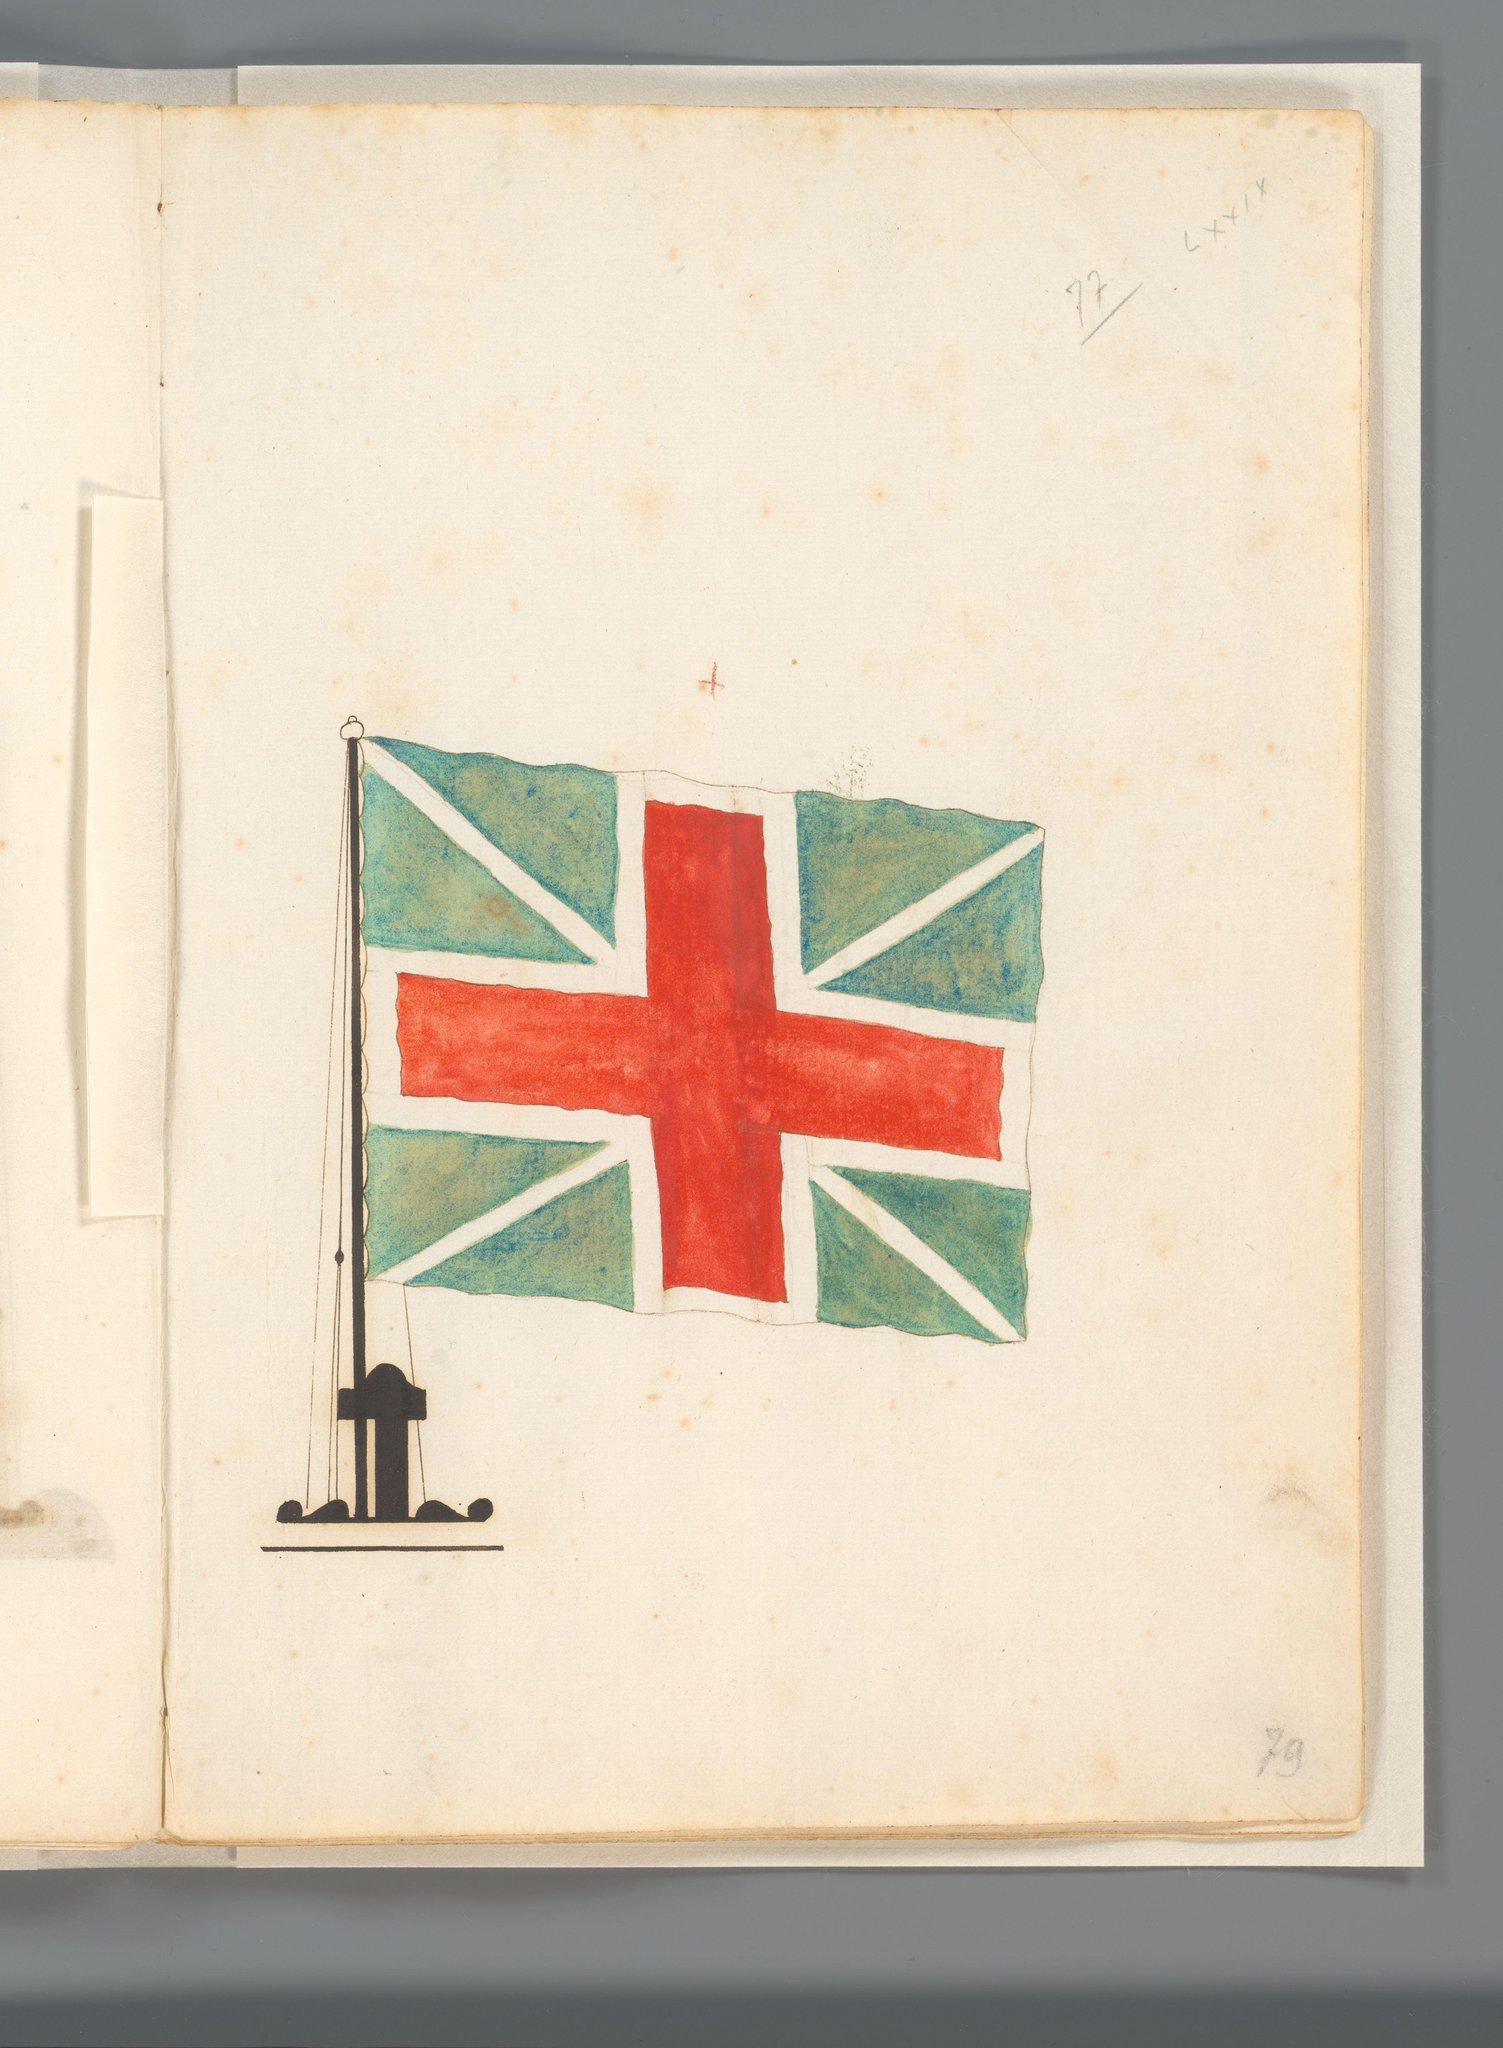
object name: drawing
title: Vlag van Groot-Brittannië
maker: Anonymous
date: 1667-1670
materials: ink, paper, watercolor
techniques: brush, pen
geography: france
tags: flag, colours (as symbol of the state, etc.), great britain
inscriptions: number: ‘77 / LXXIX / 79’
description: Vlag van Groot-Brittannië. Combinatie van het rode kruis van Sint-Joris (Saint George's Cross), de Engelse vlag, met een wit andreaskruis (St Andrew's Cross) op een blauw vlak, van Schotland. Vlag op vlaggensteng en mastvoet. Afgebeeld op folio 40r. Onderdeel van een vlaggenboek met vlaggen uit Europa, Noord-Afrika, Nabije en Verre Oosten.